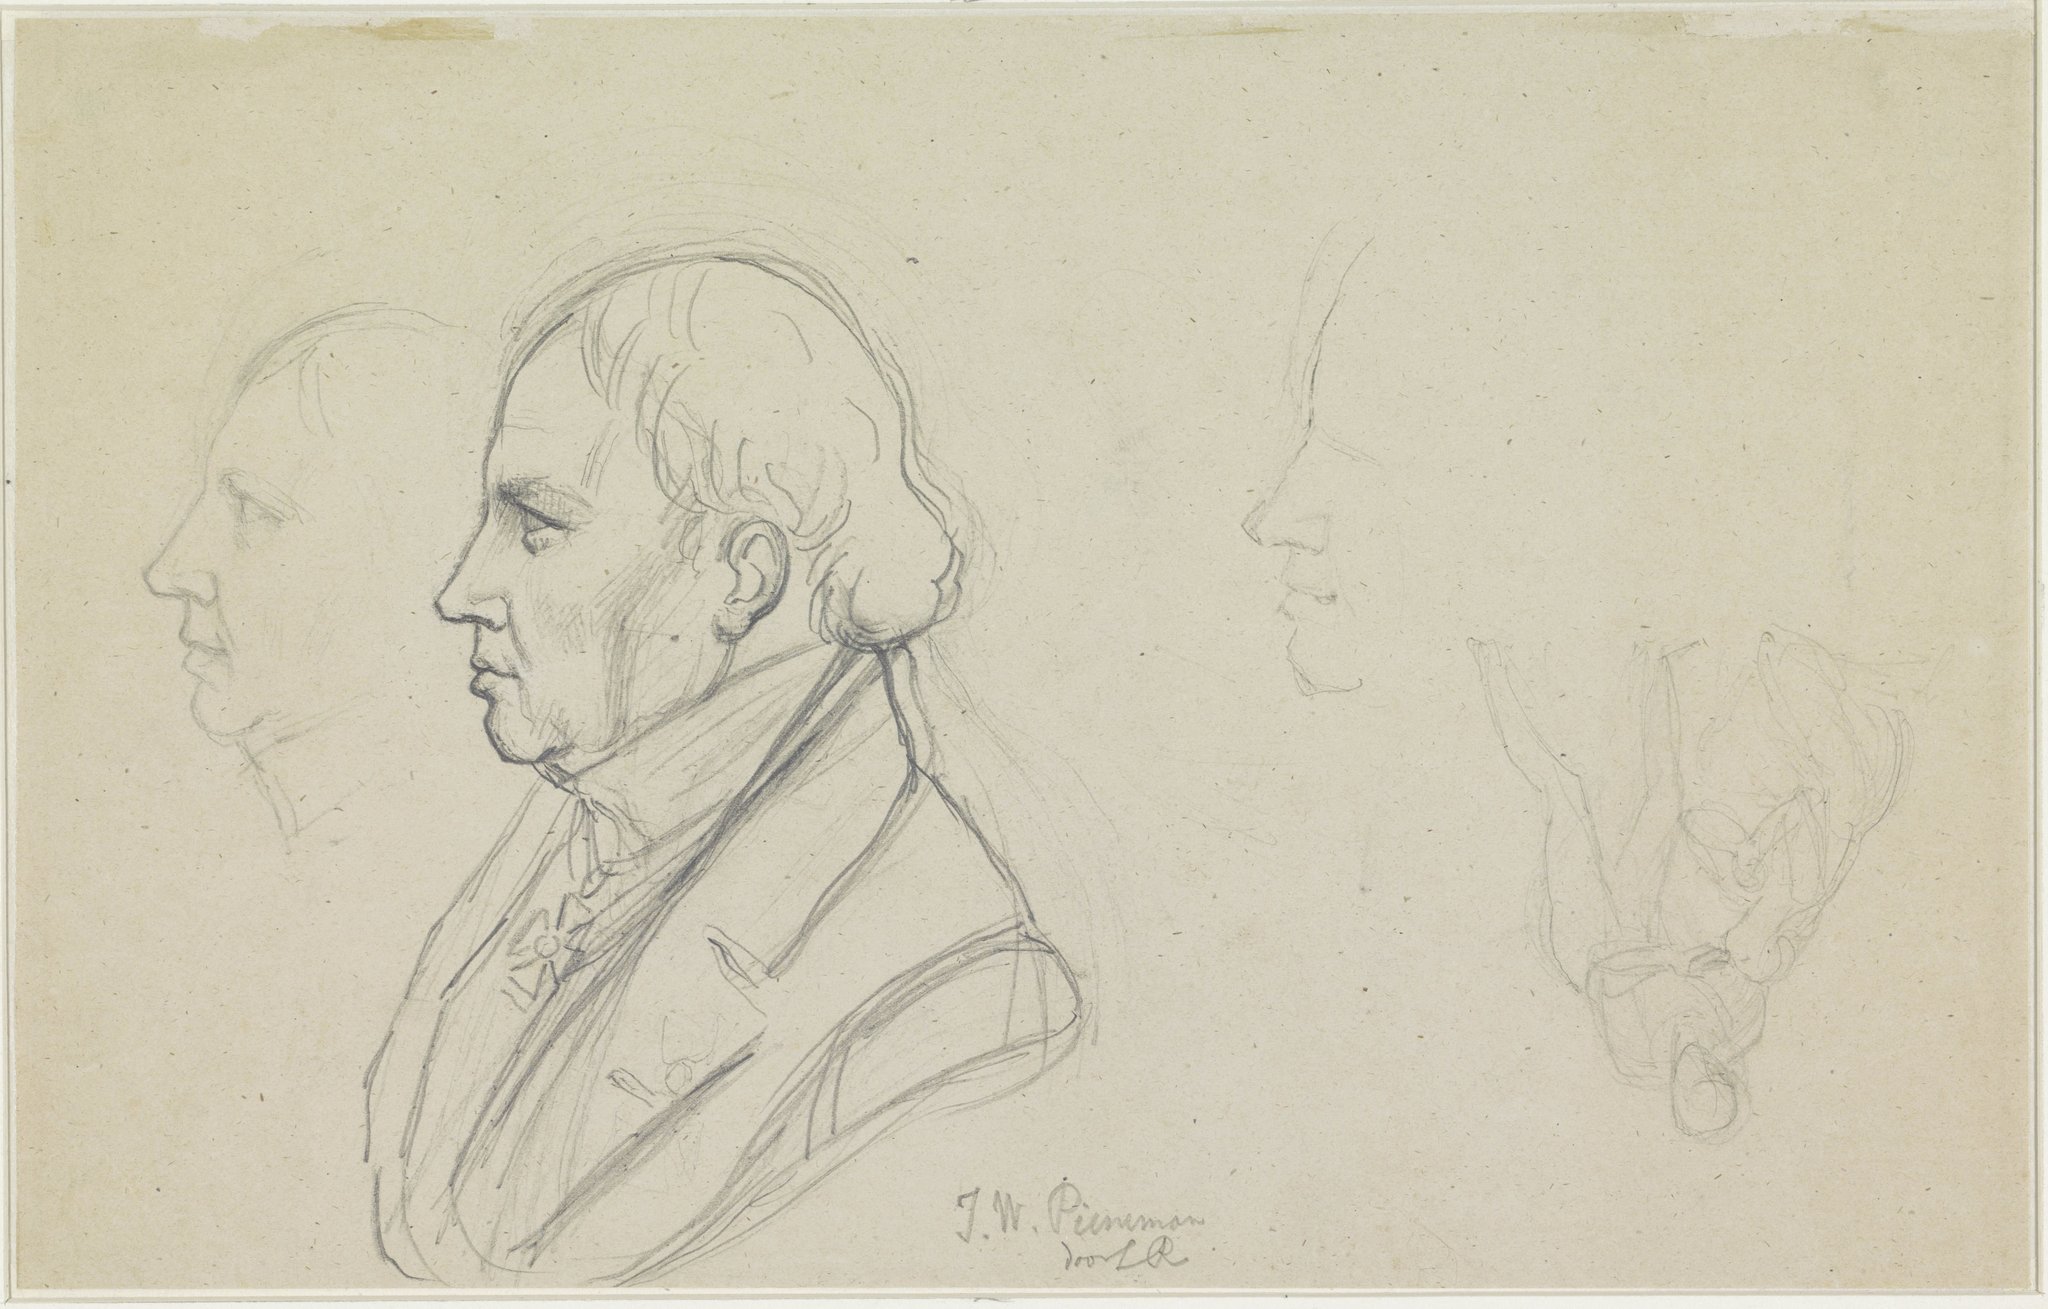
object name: design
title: Drie profielschetsen van Jan Willem Pieneman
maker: louis royer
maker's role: draughtsman, sculptor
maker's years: 1793-1868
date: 1803-1868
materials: paper, pencil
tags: painter, jan willem pieneman, historical persons, portrait, self-portrait of painter, portrait, self-portrait of artist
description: Mogelijk een ontwerp voor een beeldhouwwerk.